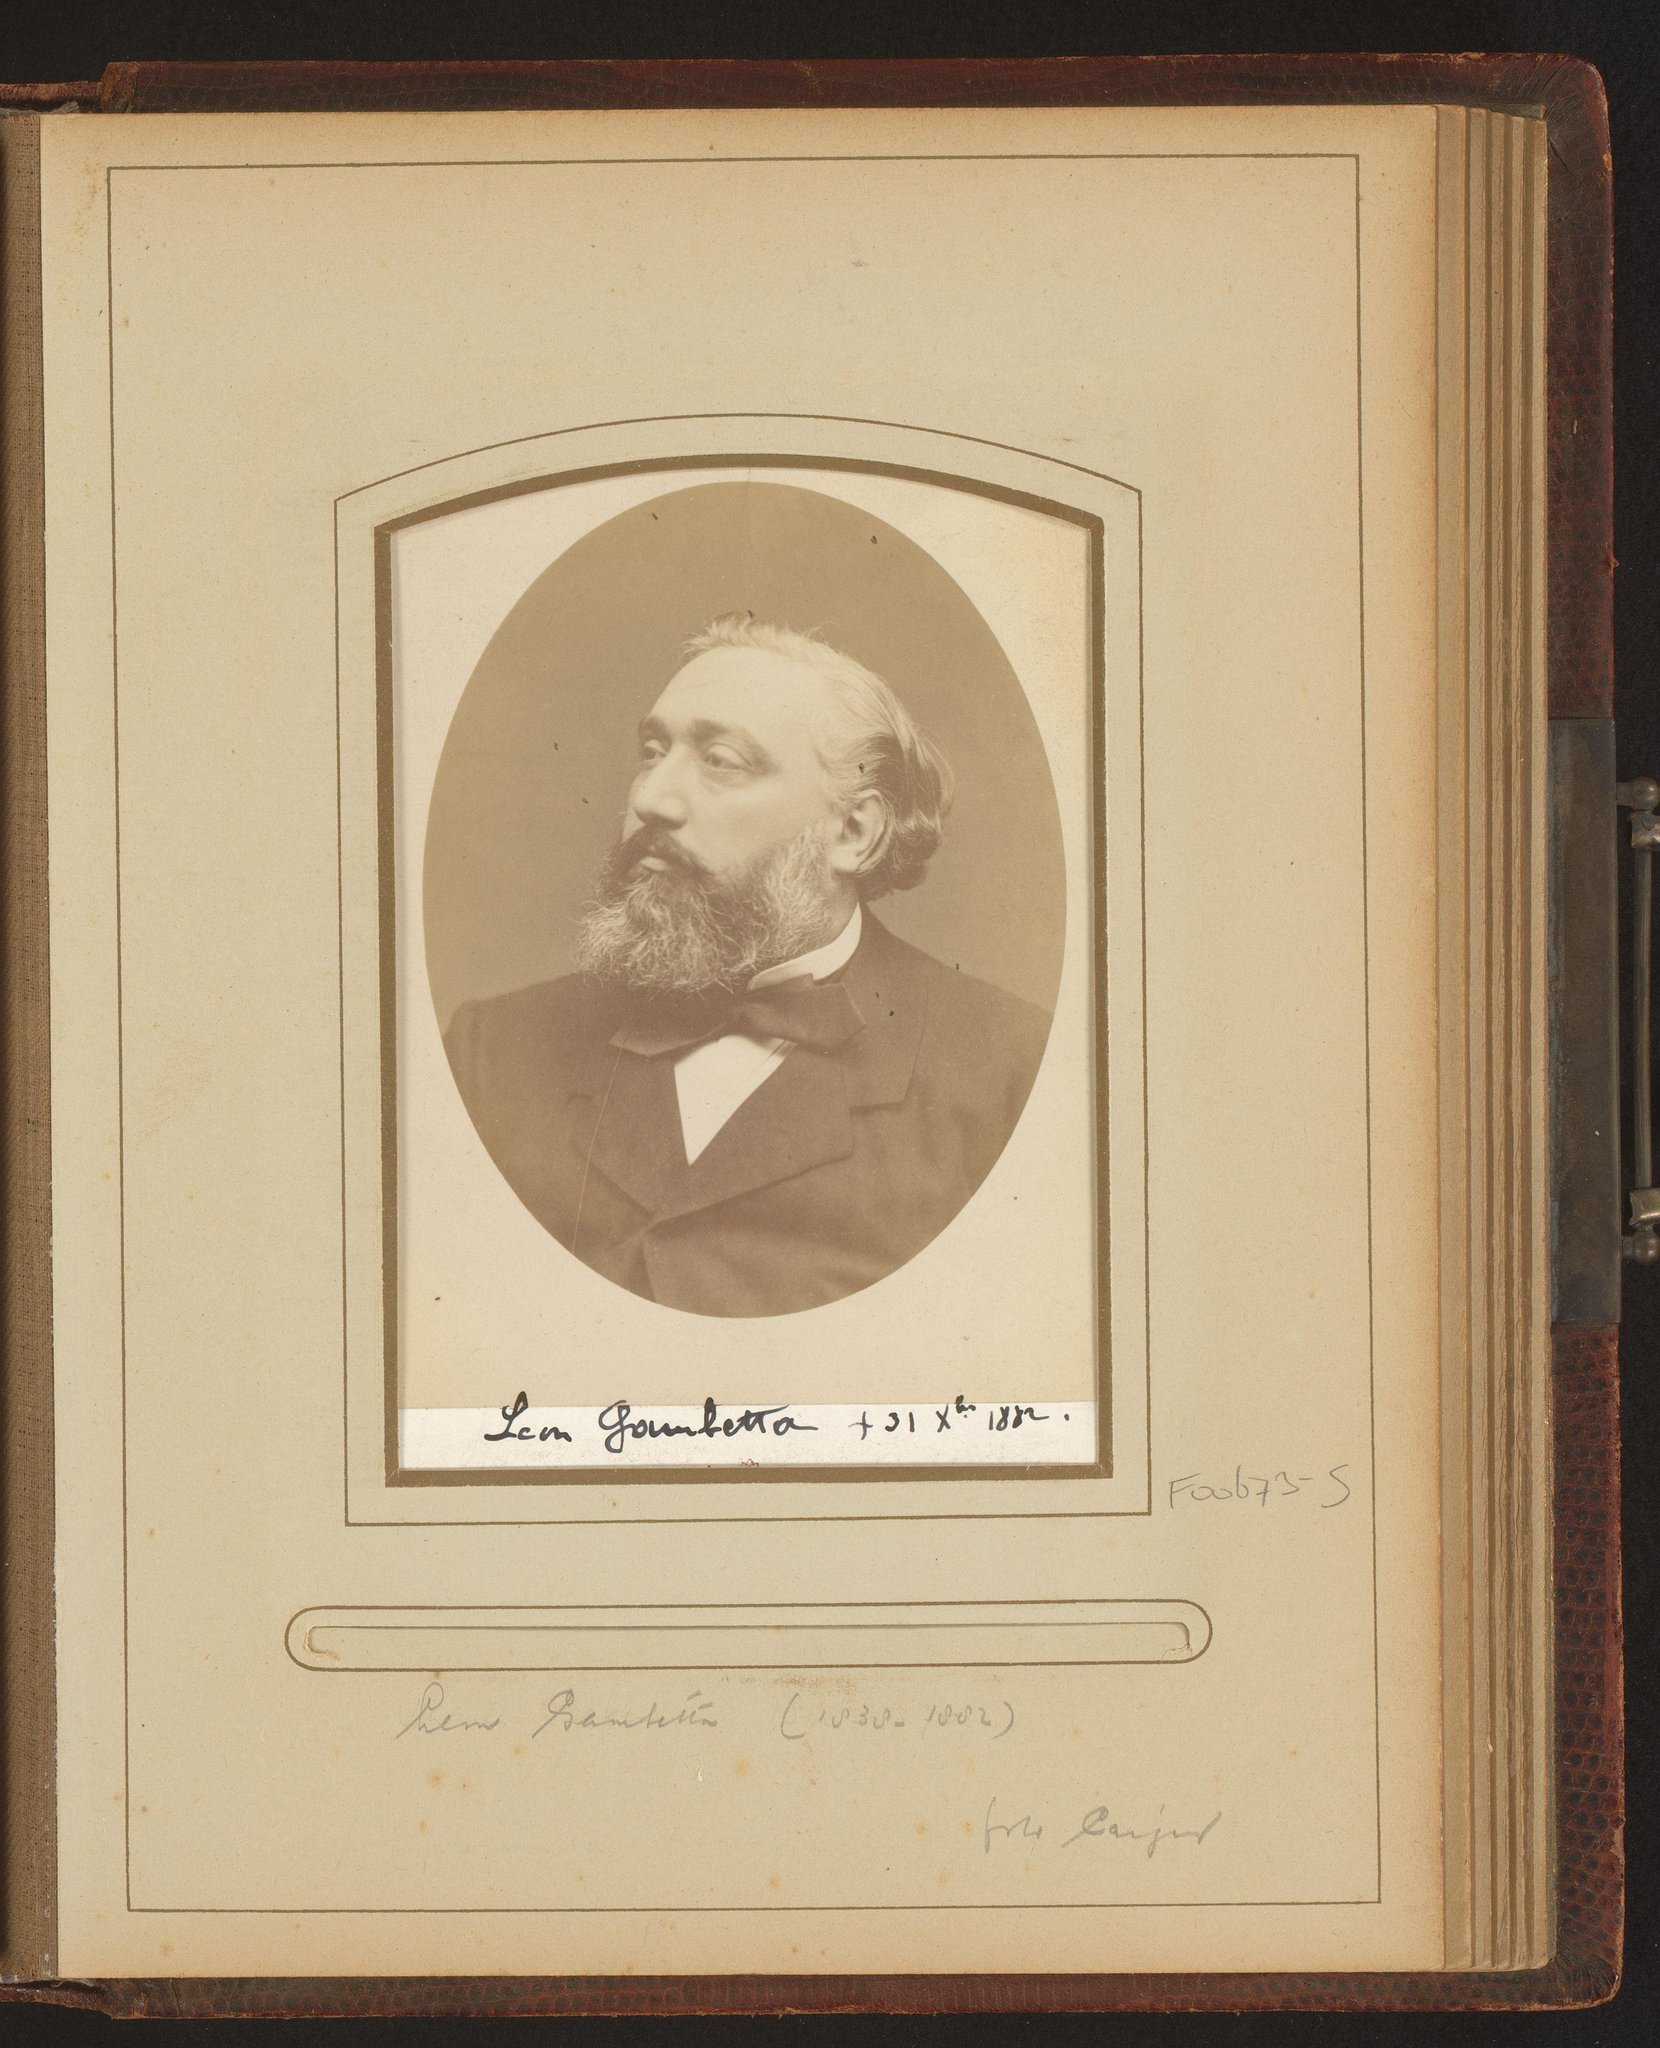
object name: photograph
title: Portret van Leon Gambetta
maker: étienne carjat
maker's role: draughtsman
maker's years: 1828-1906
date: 1867-1882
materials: cardboard, photographic support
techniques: albumen print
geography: paris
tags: historical persons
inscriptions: annotation: ‘F.L. 54’, annotation: ‘Leon Gambetta (1838 - 1882)/ foto Carjat’, annotation: ‘Leon Gambetta +31 x[...] 1882’